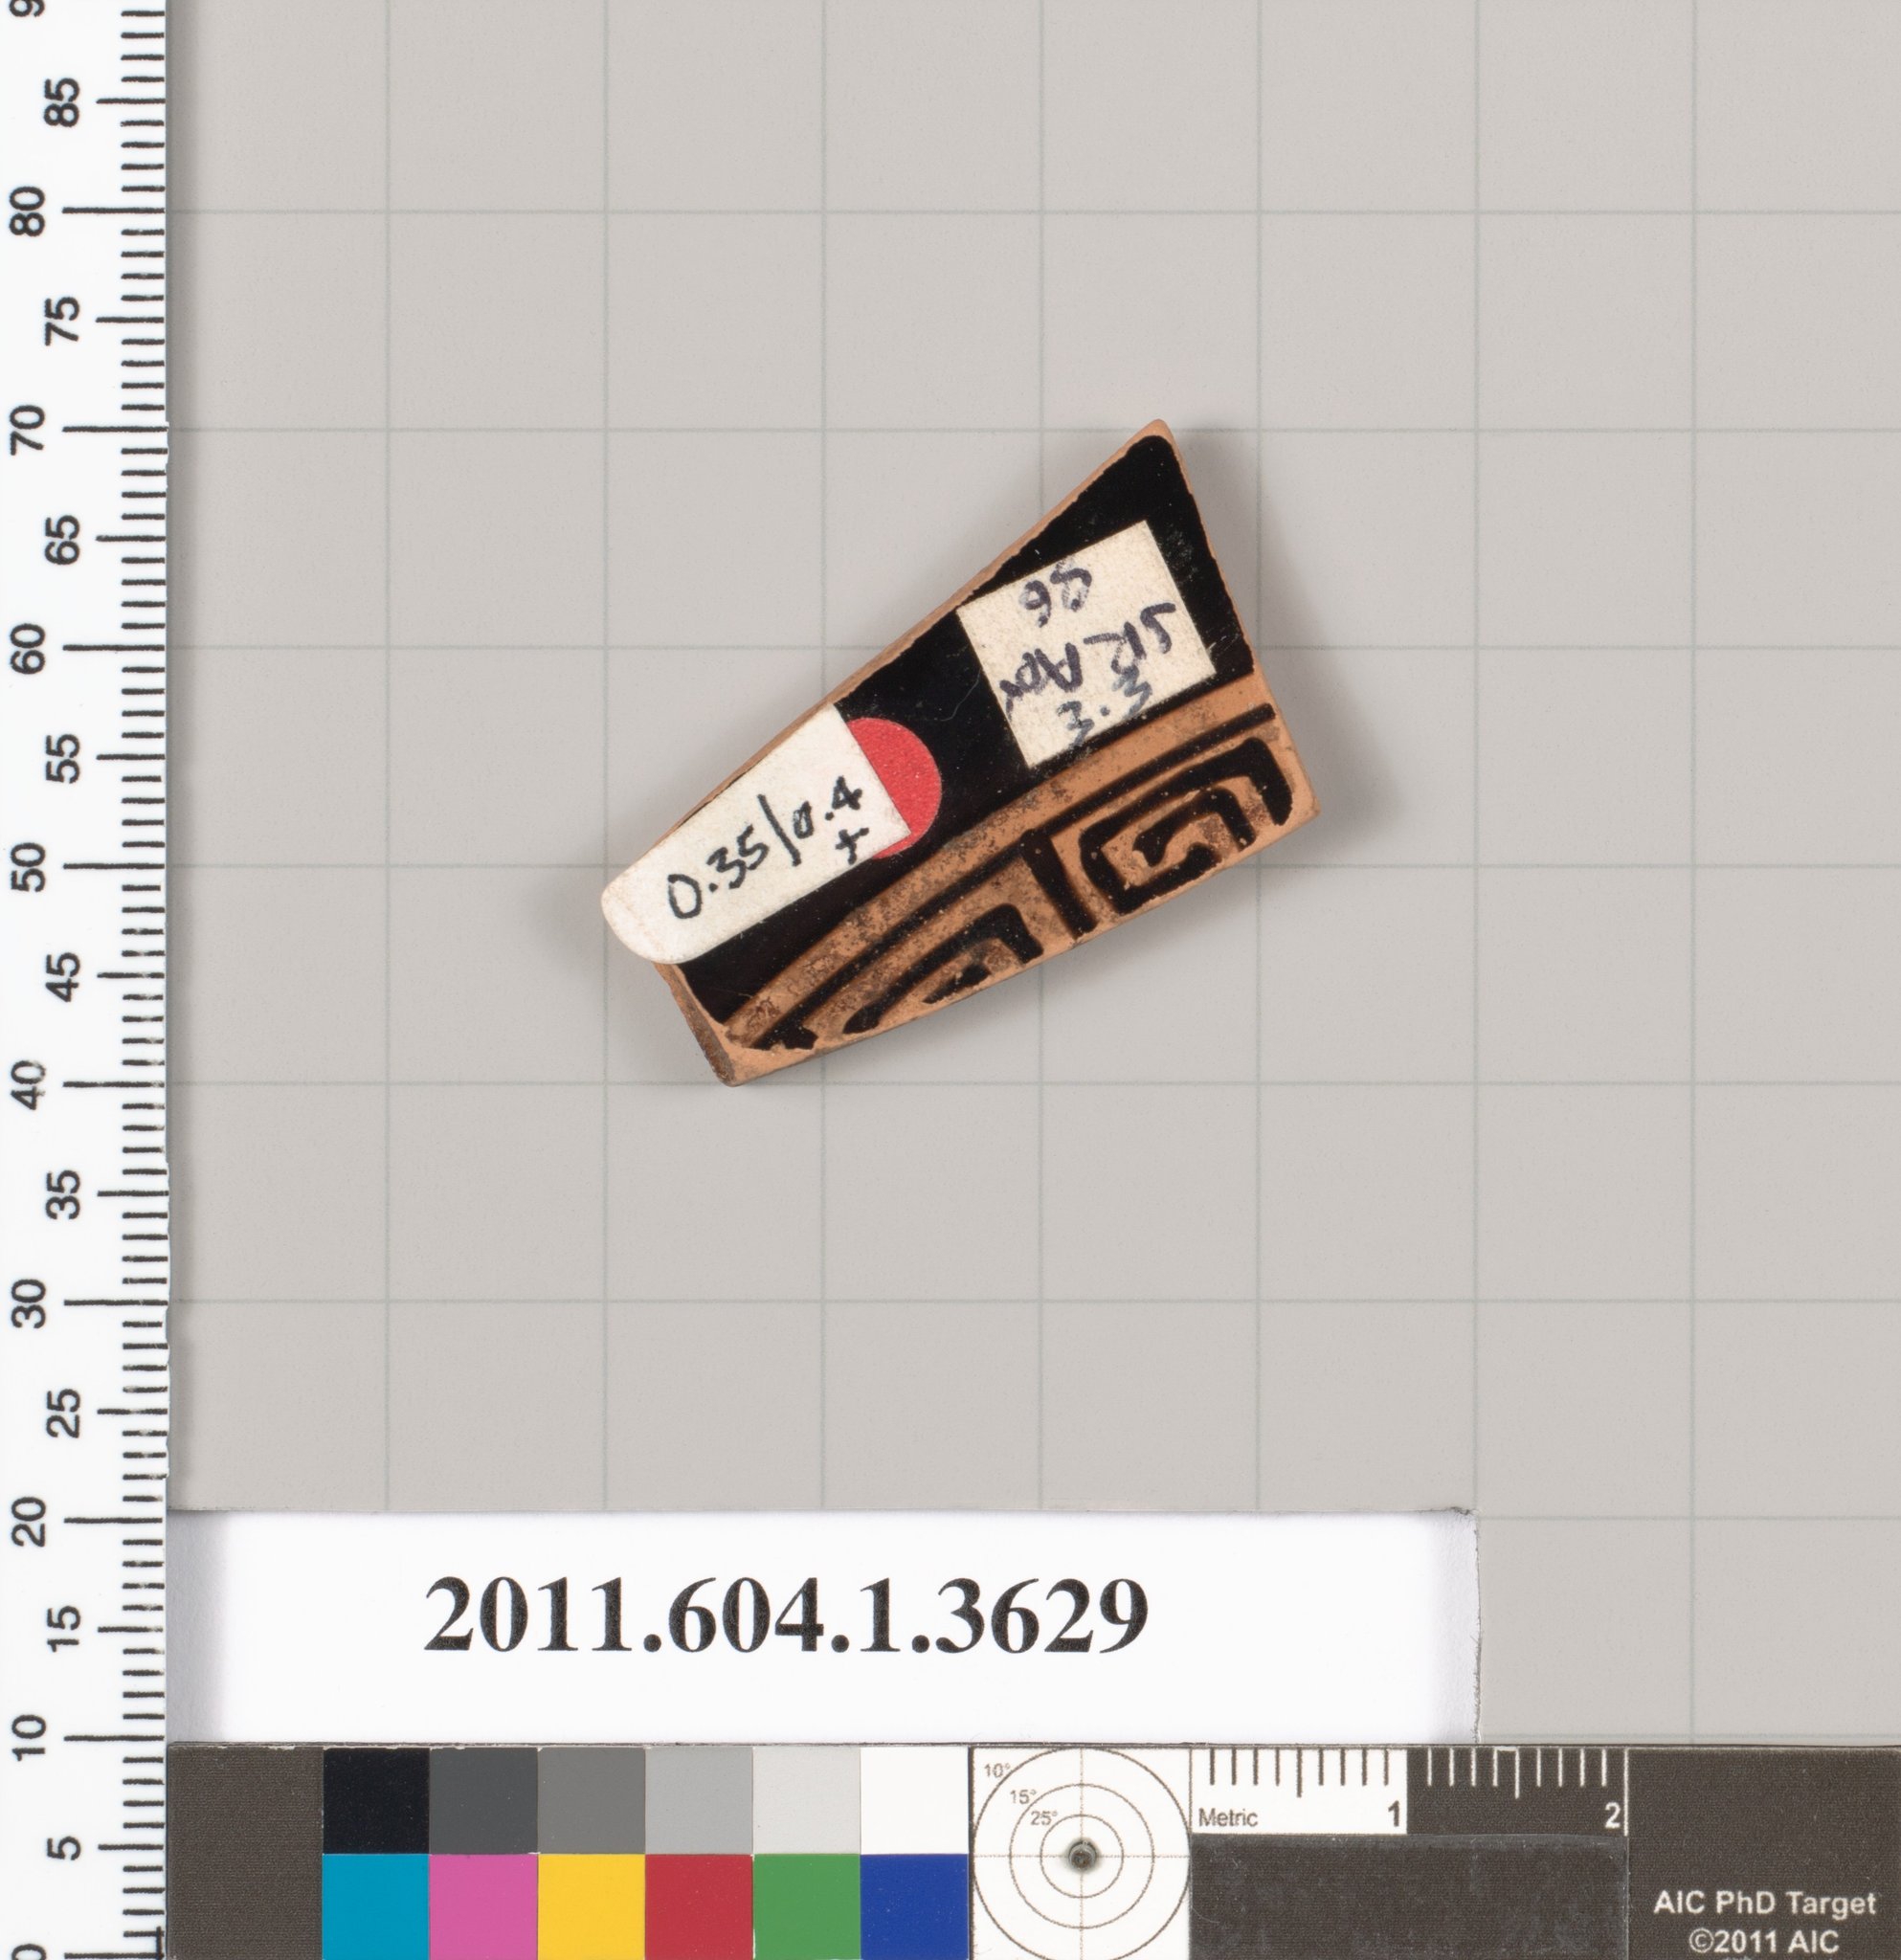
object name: kylix fragment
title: Terracotta fragment of a kylix (drinking cup)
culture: greek, attic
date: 490-480 BCE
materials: terracotta